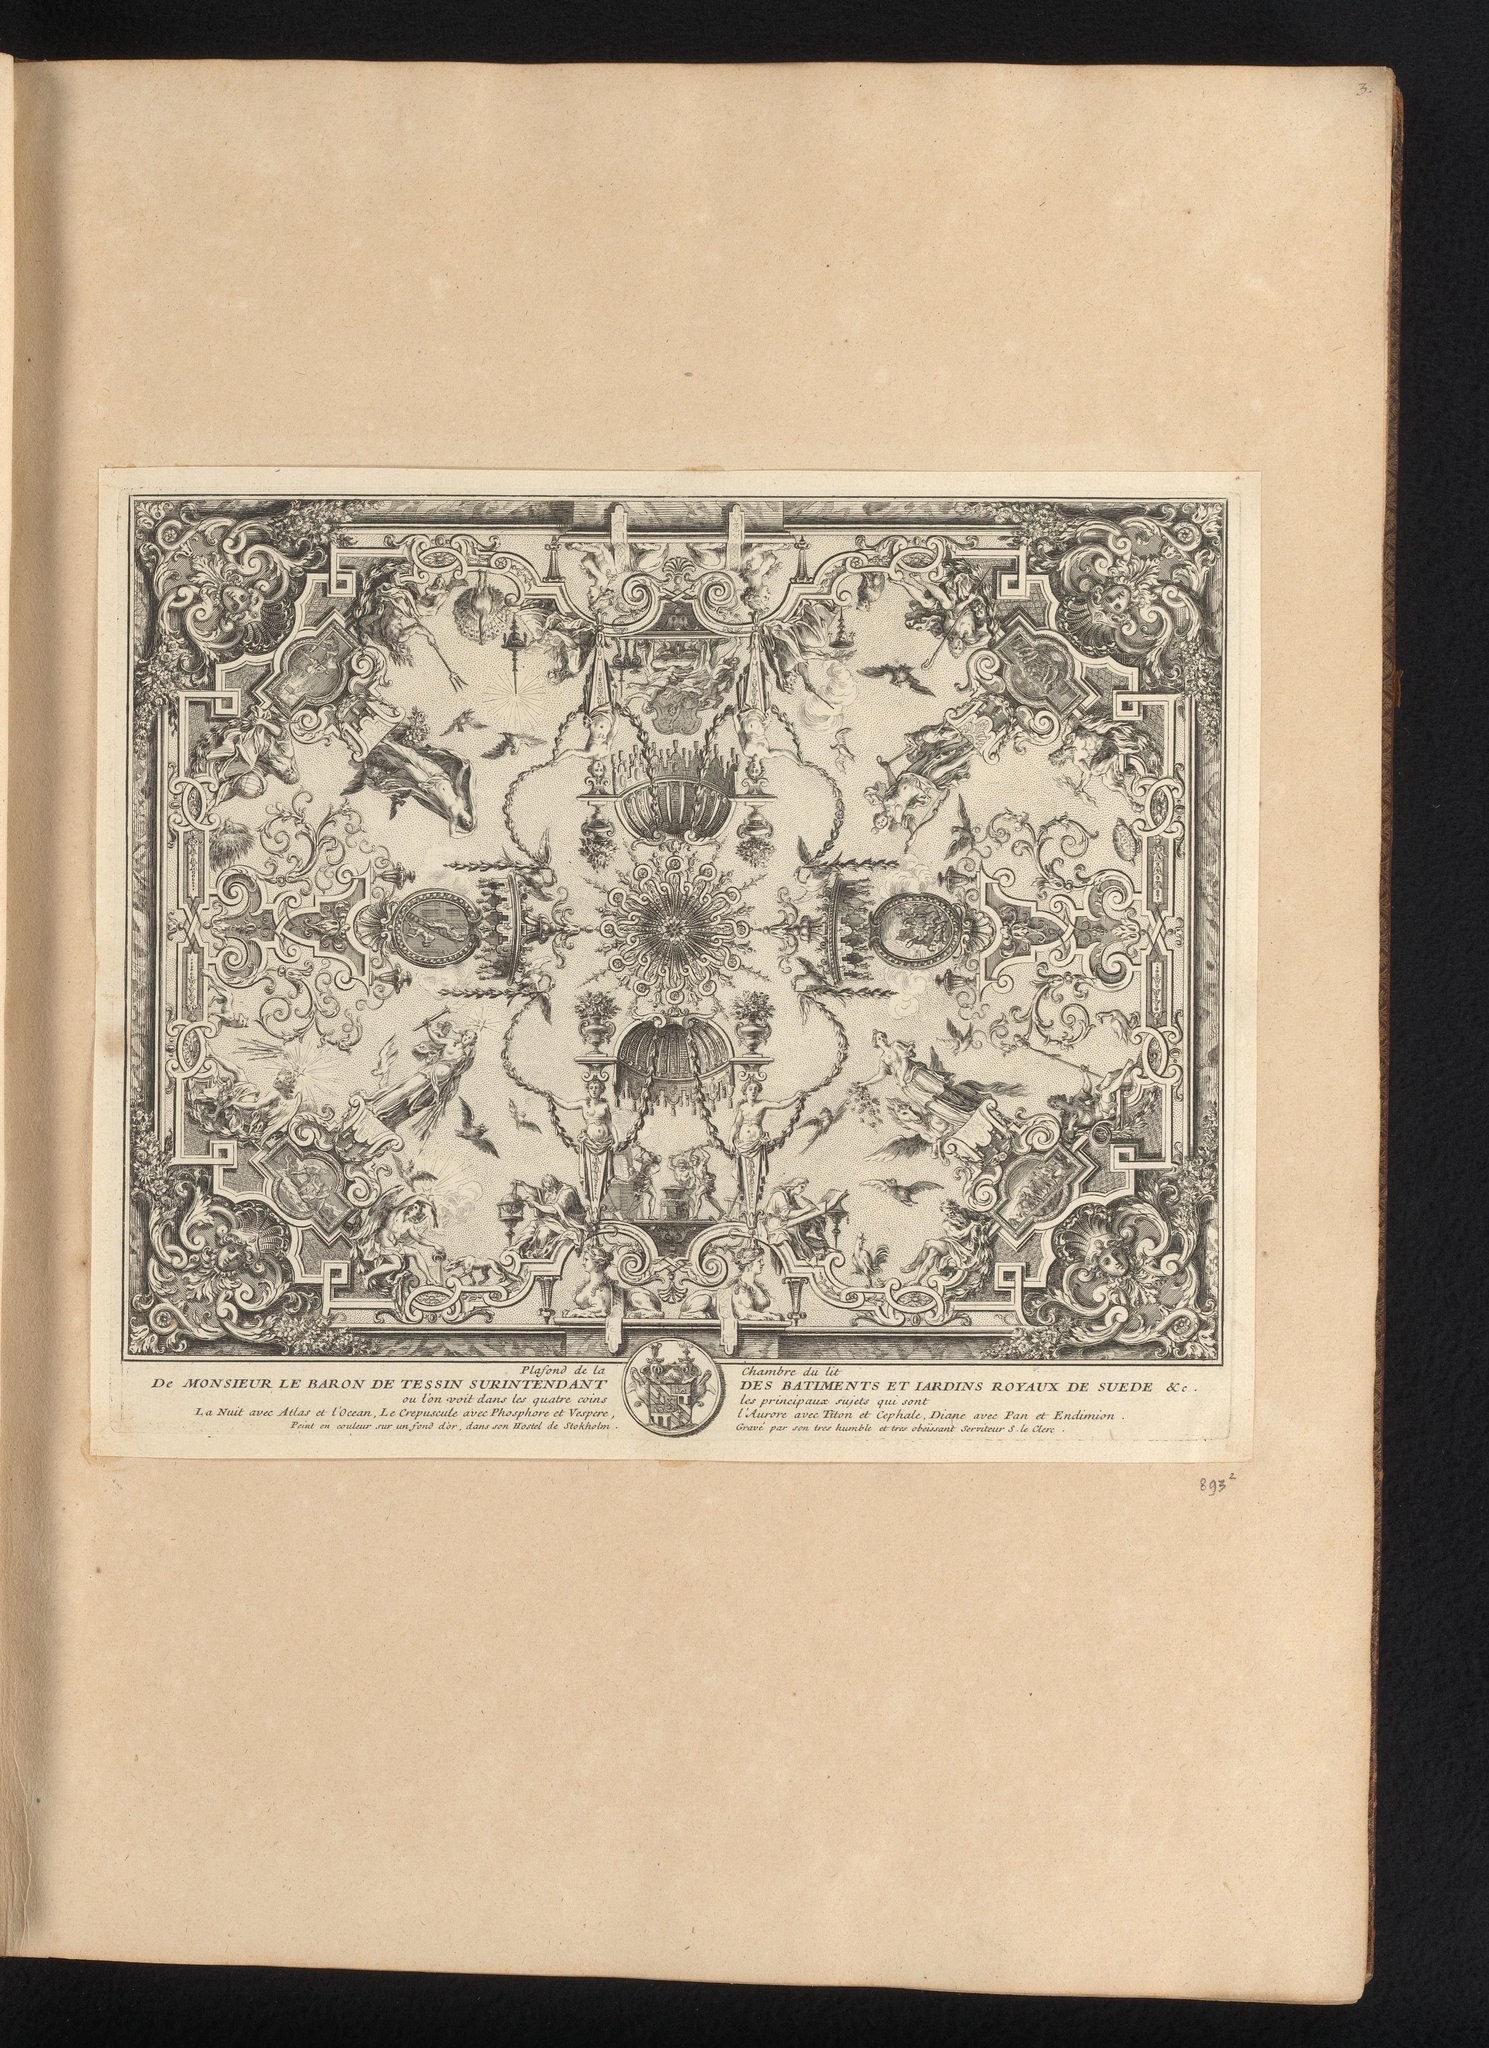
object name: album leaf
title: Plafond de la Chambre du lit (...)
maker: sébastien leclerc (i)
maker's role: print maker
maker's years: 1637-1714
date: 1699-1702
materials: paper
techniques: etching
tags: day of 24 hours, natural day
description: Prent naar een gedecoreerd plafond in de slaapkamer van Baron Nicodemus de Tessin in Stockholm. Prent maakt deel uit van een album.